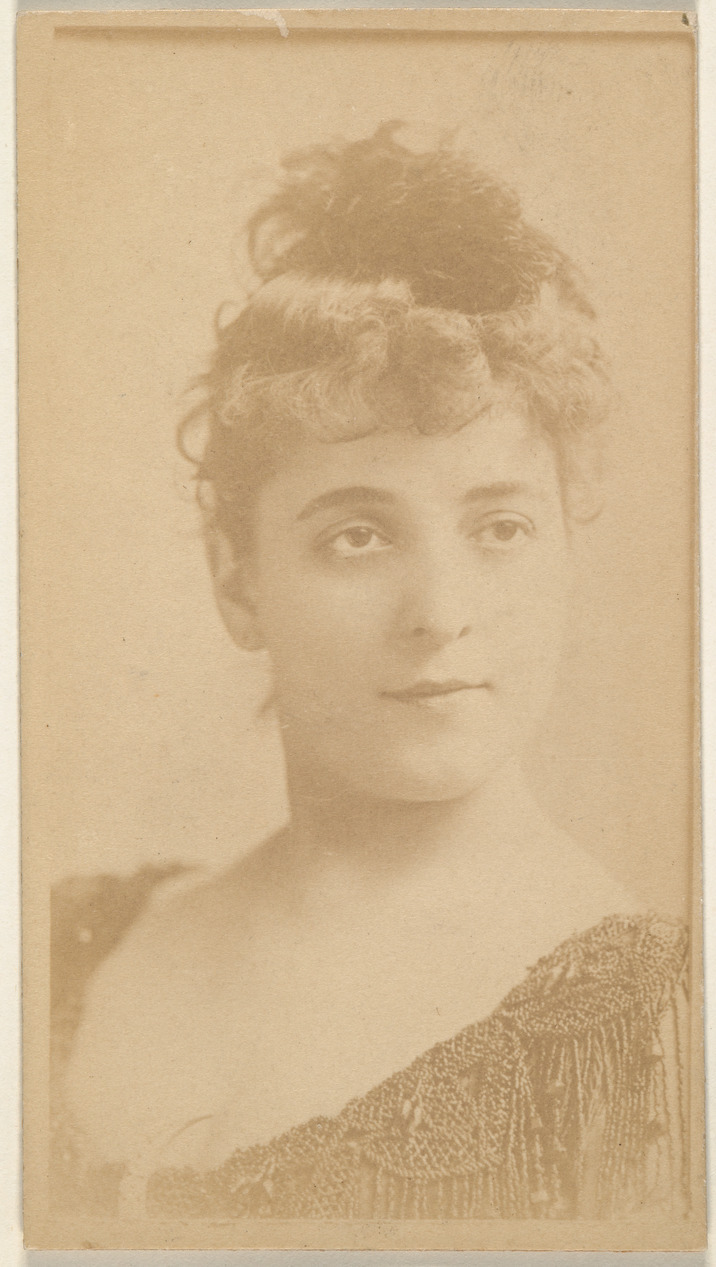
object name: photograph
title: Portrait of actress, from the Actresses series (N668)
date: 1888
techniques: albumen silver print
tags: portraits,women,actresses